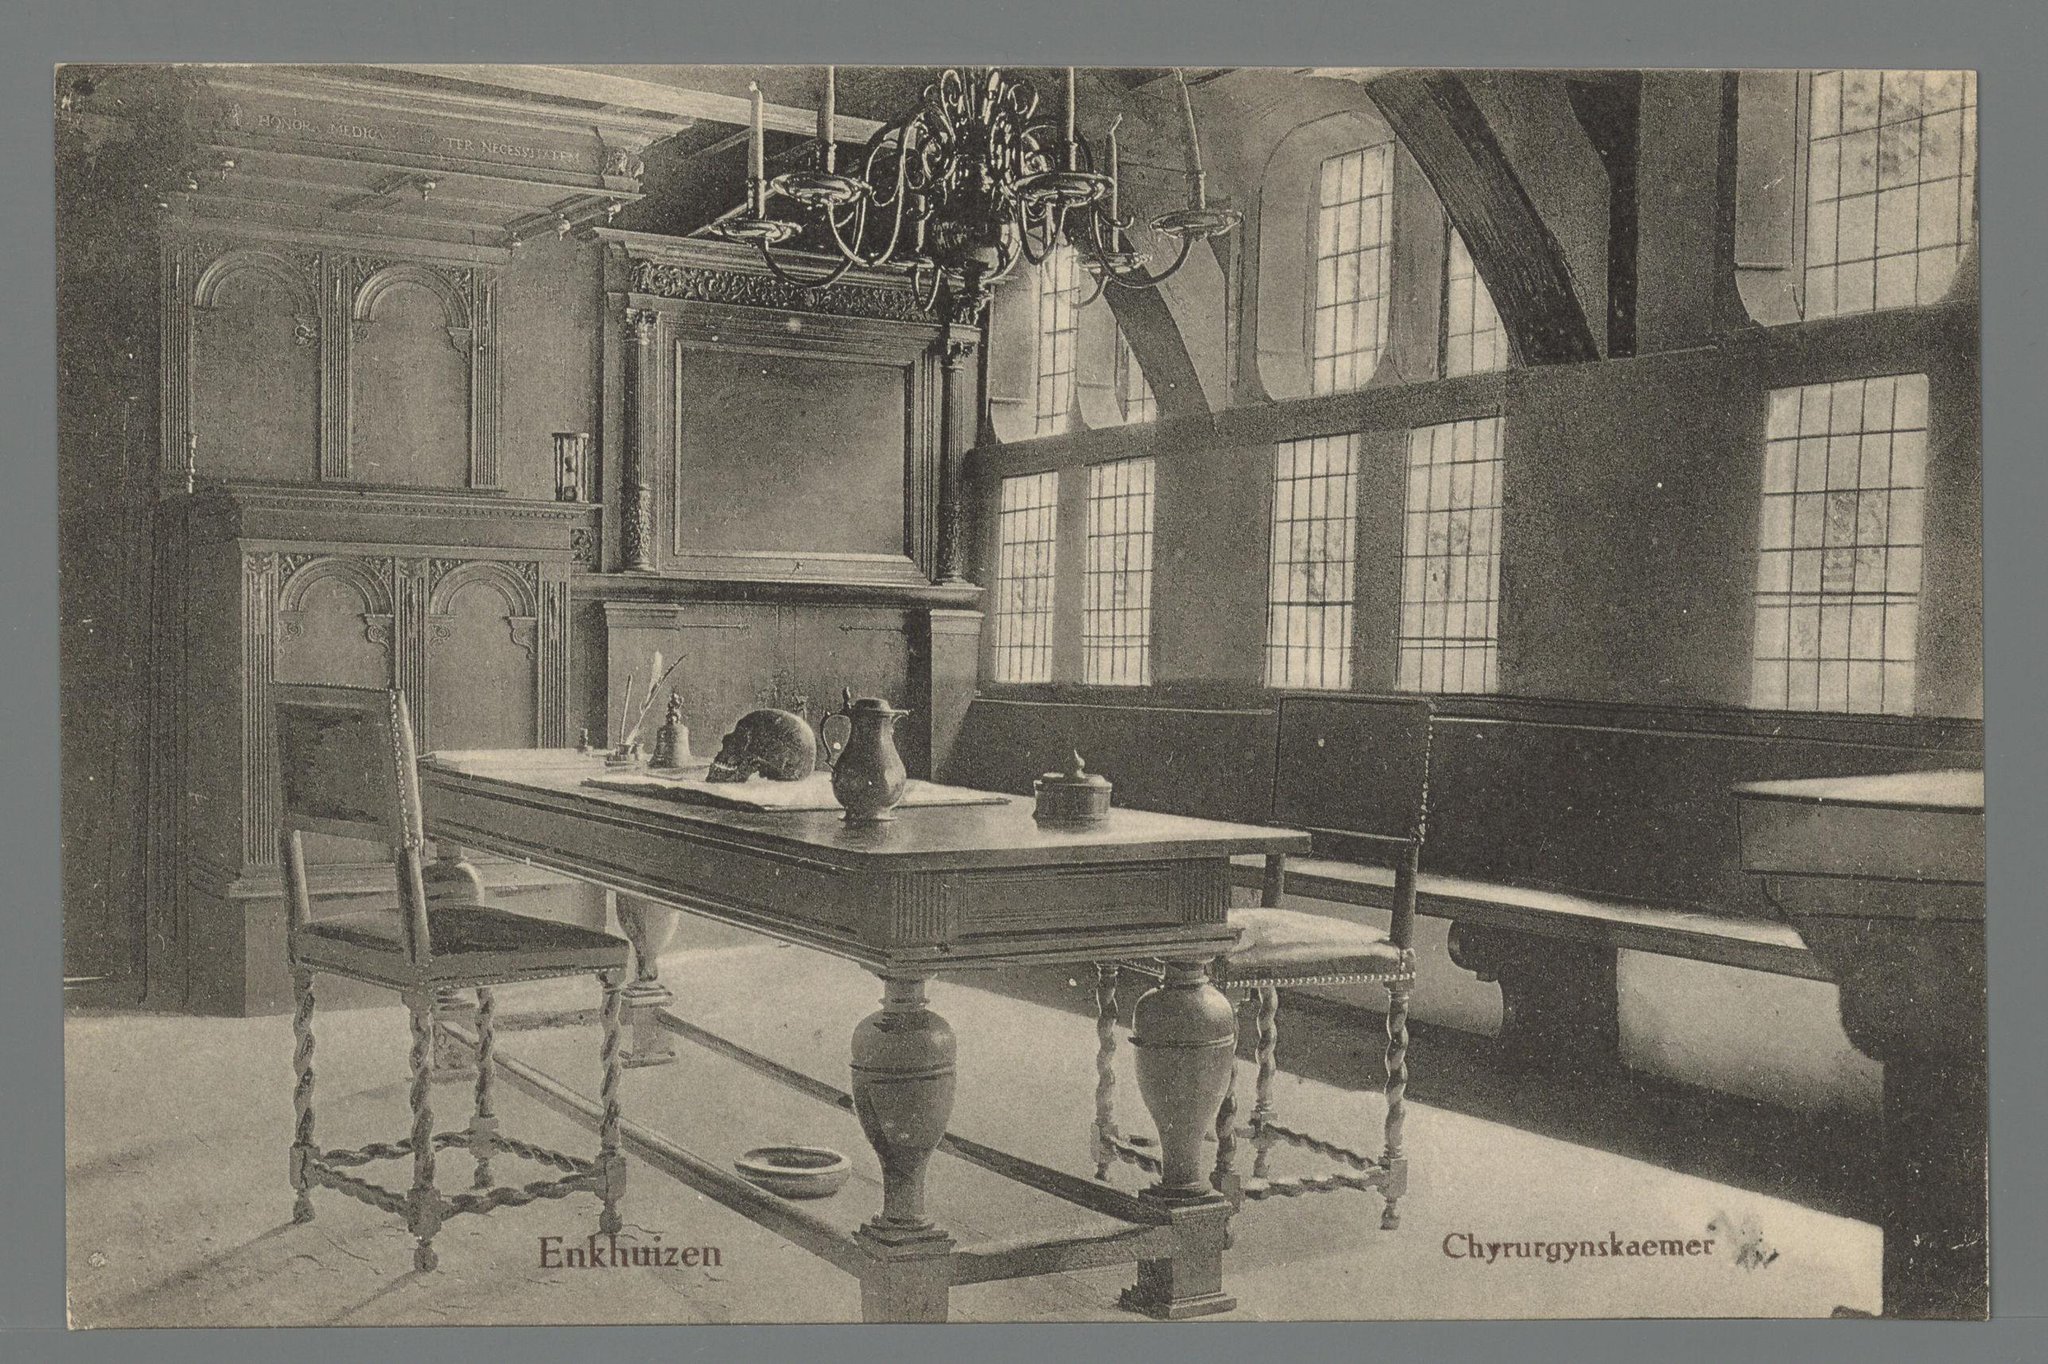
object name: photomechanical print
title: Enkhuizen. Chyrurgynskaemer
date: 1909-1930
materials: cardboard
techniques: photograph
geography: amsterdam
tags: (human) skull, permanent exhibition, museum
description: De chirurgijnskamer bevond zich in het Waagmuseum te Enkhuizen.